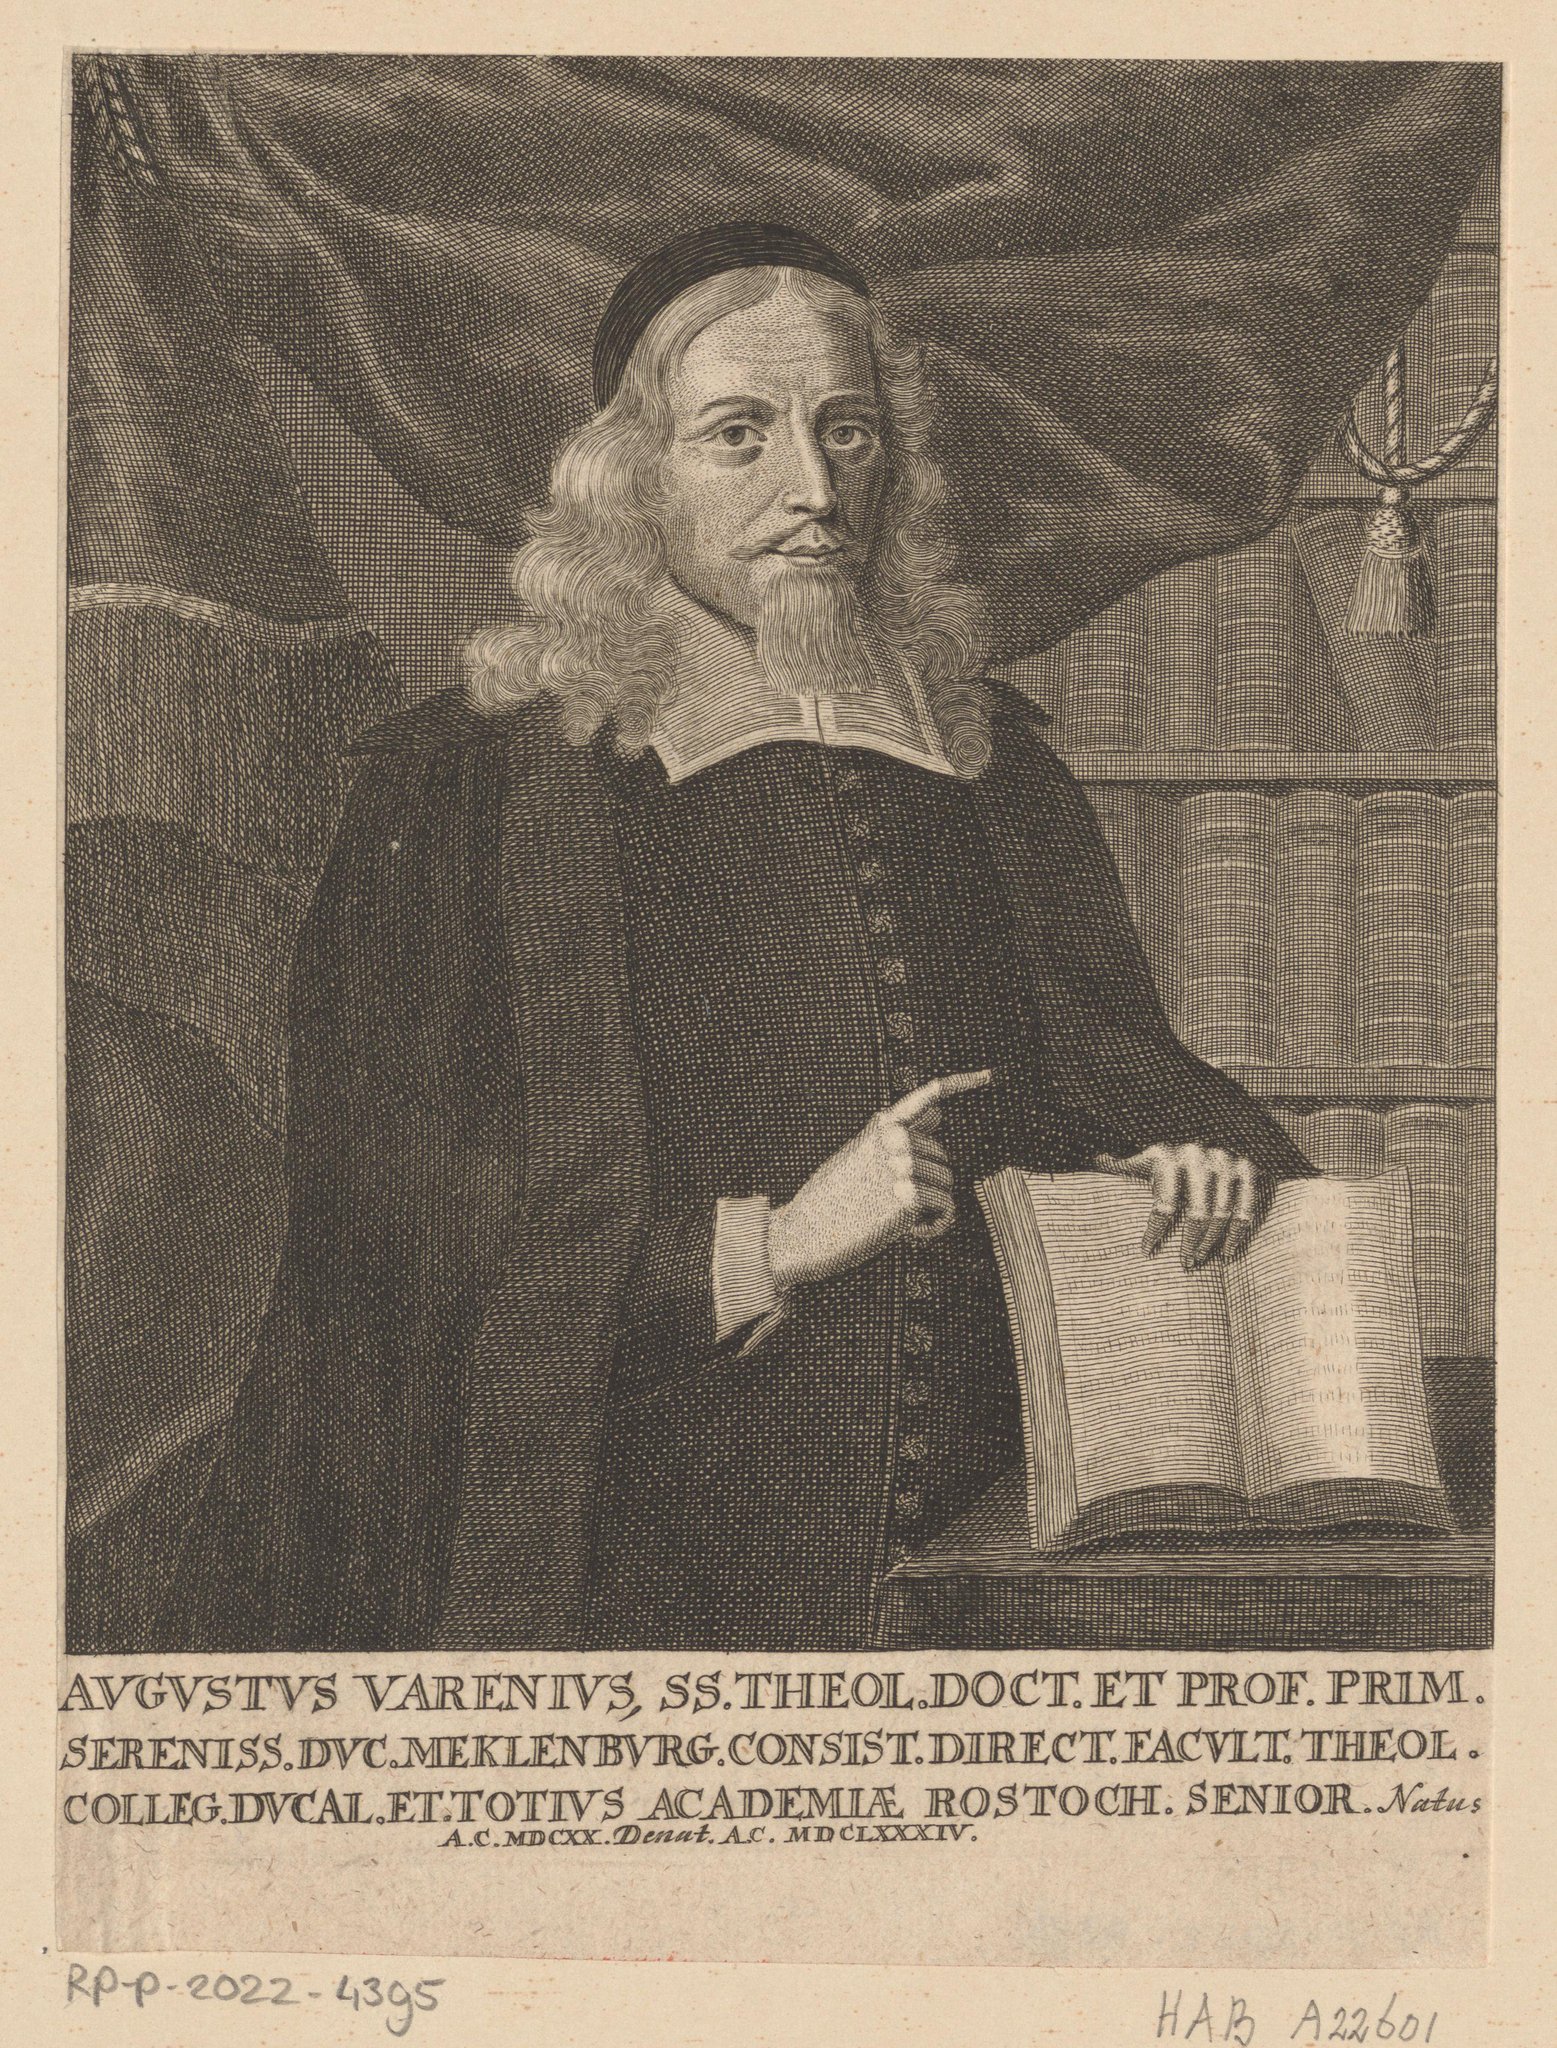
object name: print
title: Portret van August Varenius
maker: Anonymous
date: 1708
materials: paper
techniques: engraving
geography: germany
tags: curtains, bookshelves, theologian, historical persons, book - mm - book open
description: Prent waarschijnlijk uit: Varenius, August. Augusti Varenii, SS. Theologiae Doctoris (...) Commentarius in Prophetam Isaiam. Rostock en Leipzig: Johannes Heinrich Russworm, 1708.